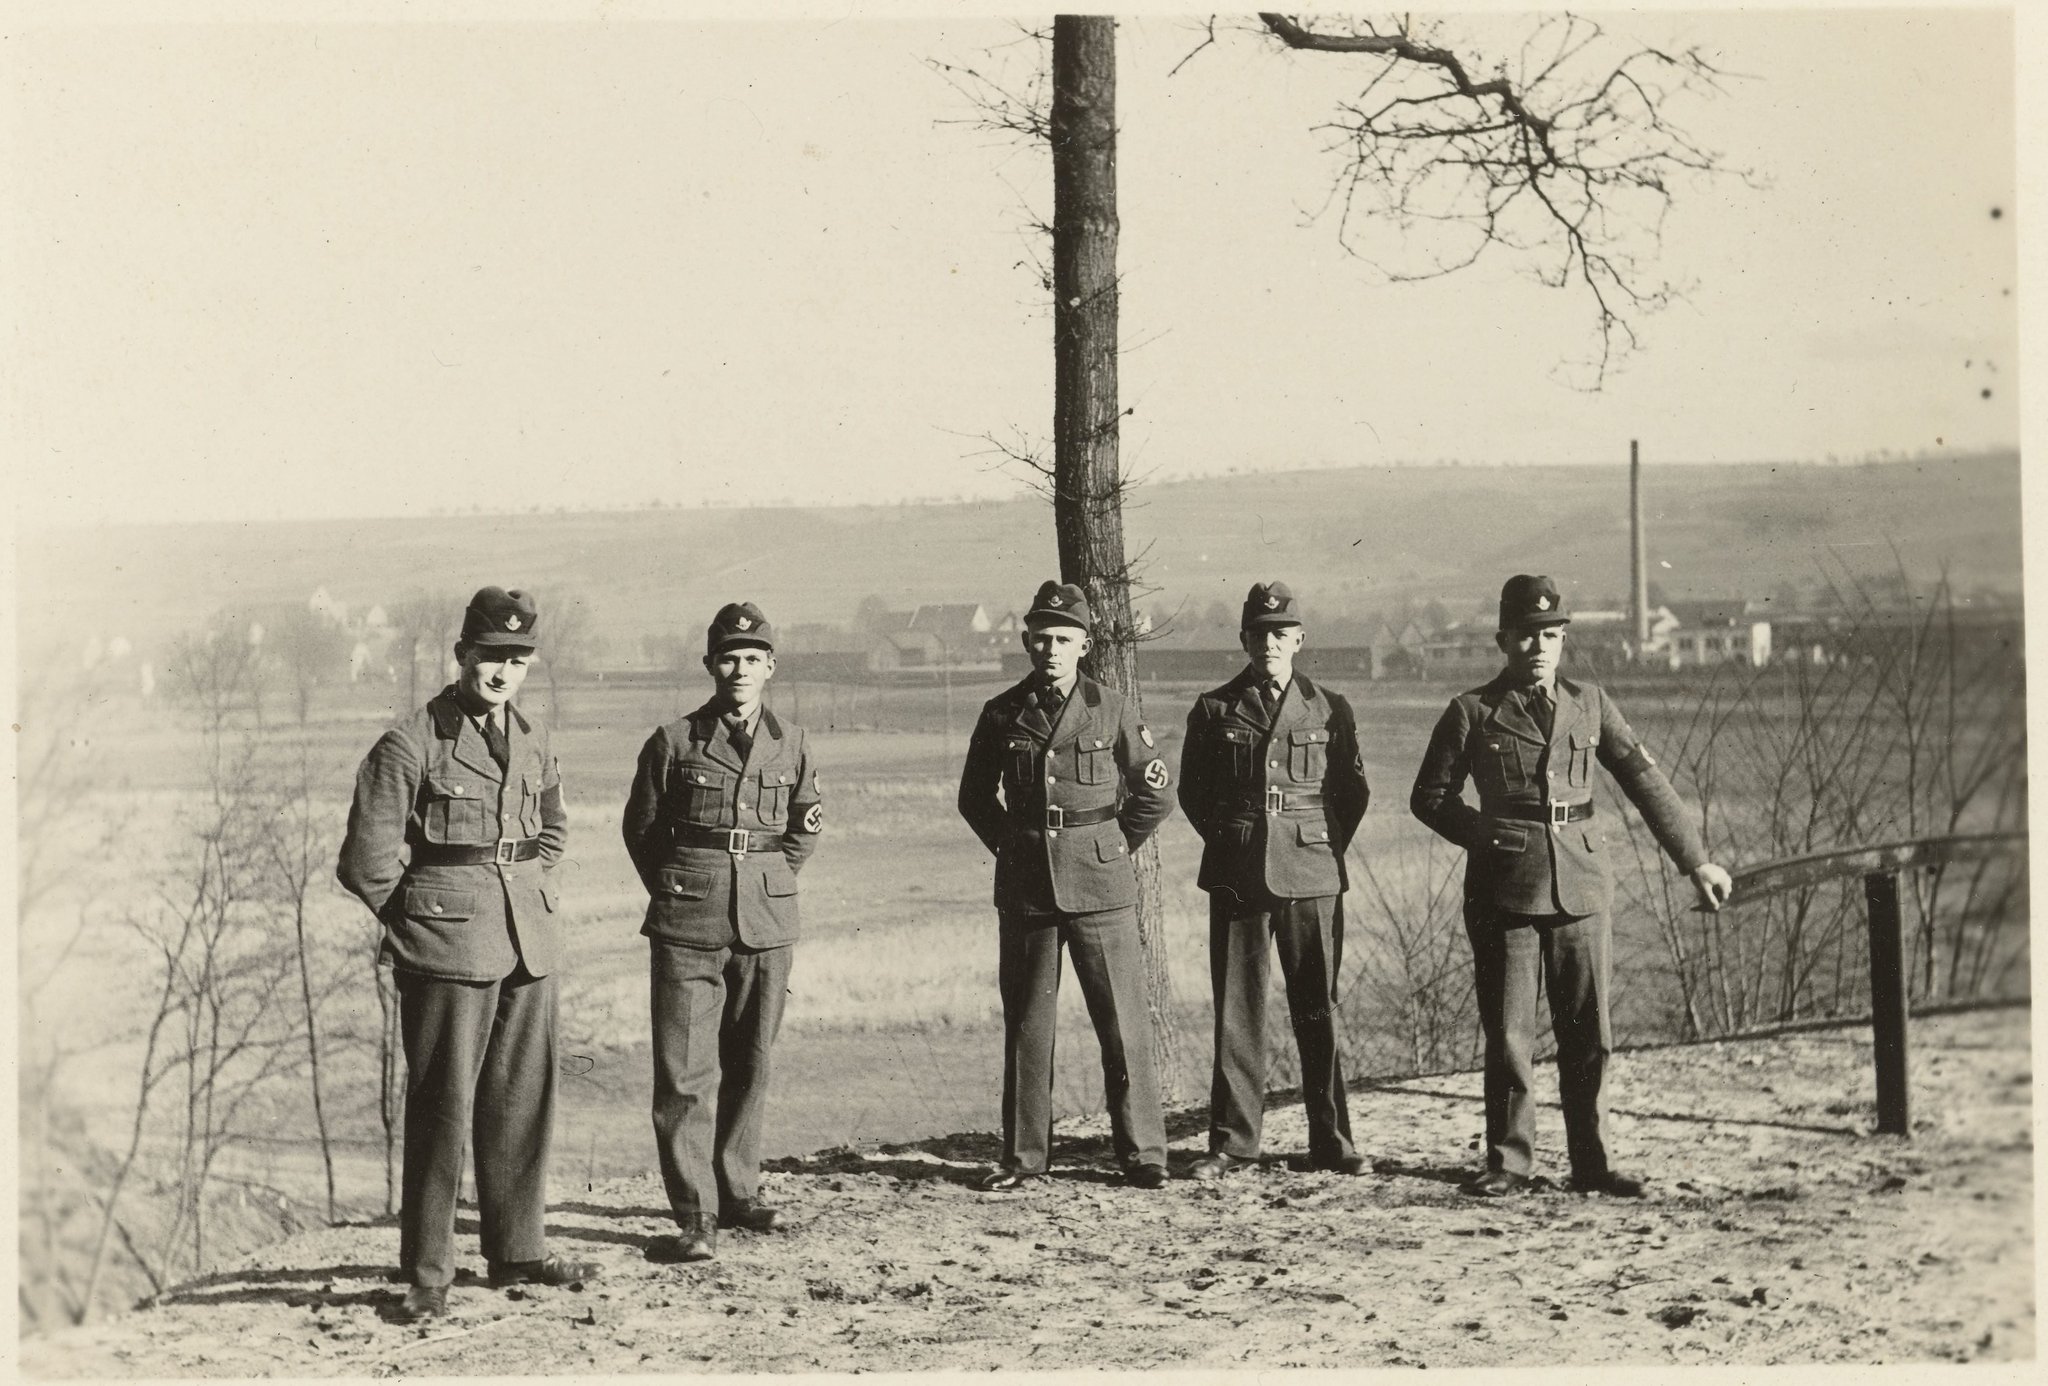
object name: photograph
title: Duitse militairen in een landschap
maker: Anonymous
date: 1940-1945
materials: photographic support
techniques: gelatin silver print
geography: germany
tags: netherlands, germany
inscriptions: stamp: ‘Foto Endmann E2208 Zweibrücken’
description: Vijf leden van de Reichsarbeitsdienst staande in een landschap met heuvels, mogelijk Zweibrücken. Foto behorend bij album 'Kriegserinnerungen'.